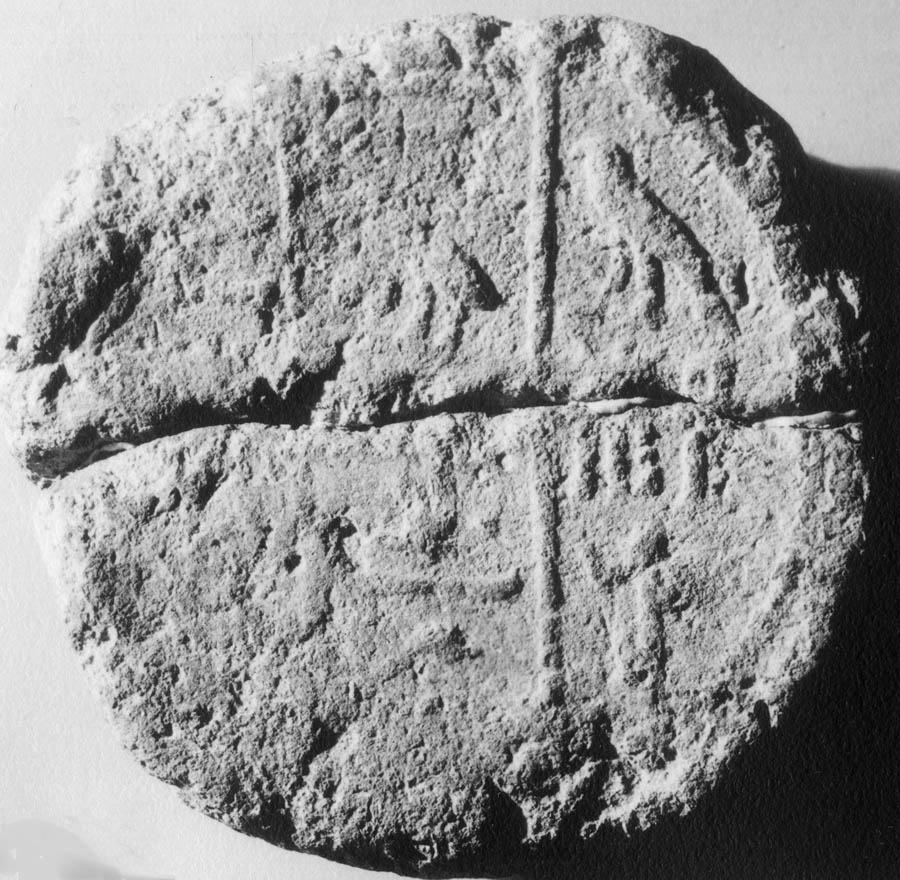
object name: cone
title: Funerary Cone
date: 1550-1295 BCE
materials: pottery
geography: egypt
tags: hieroglyphs